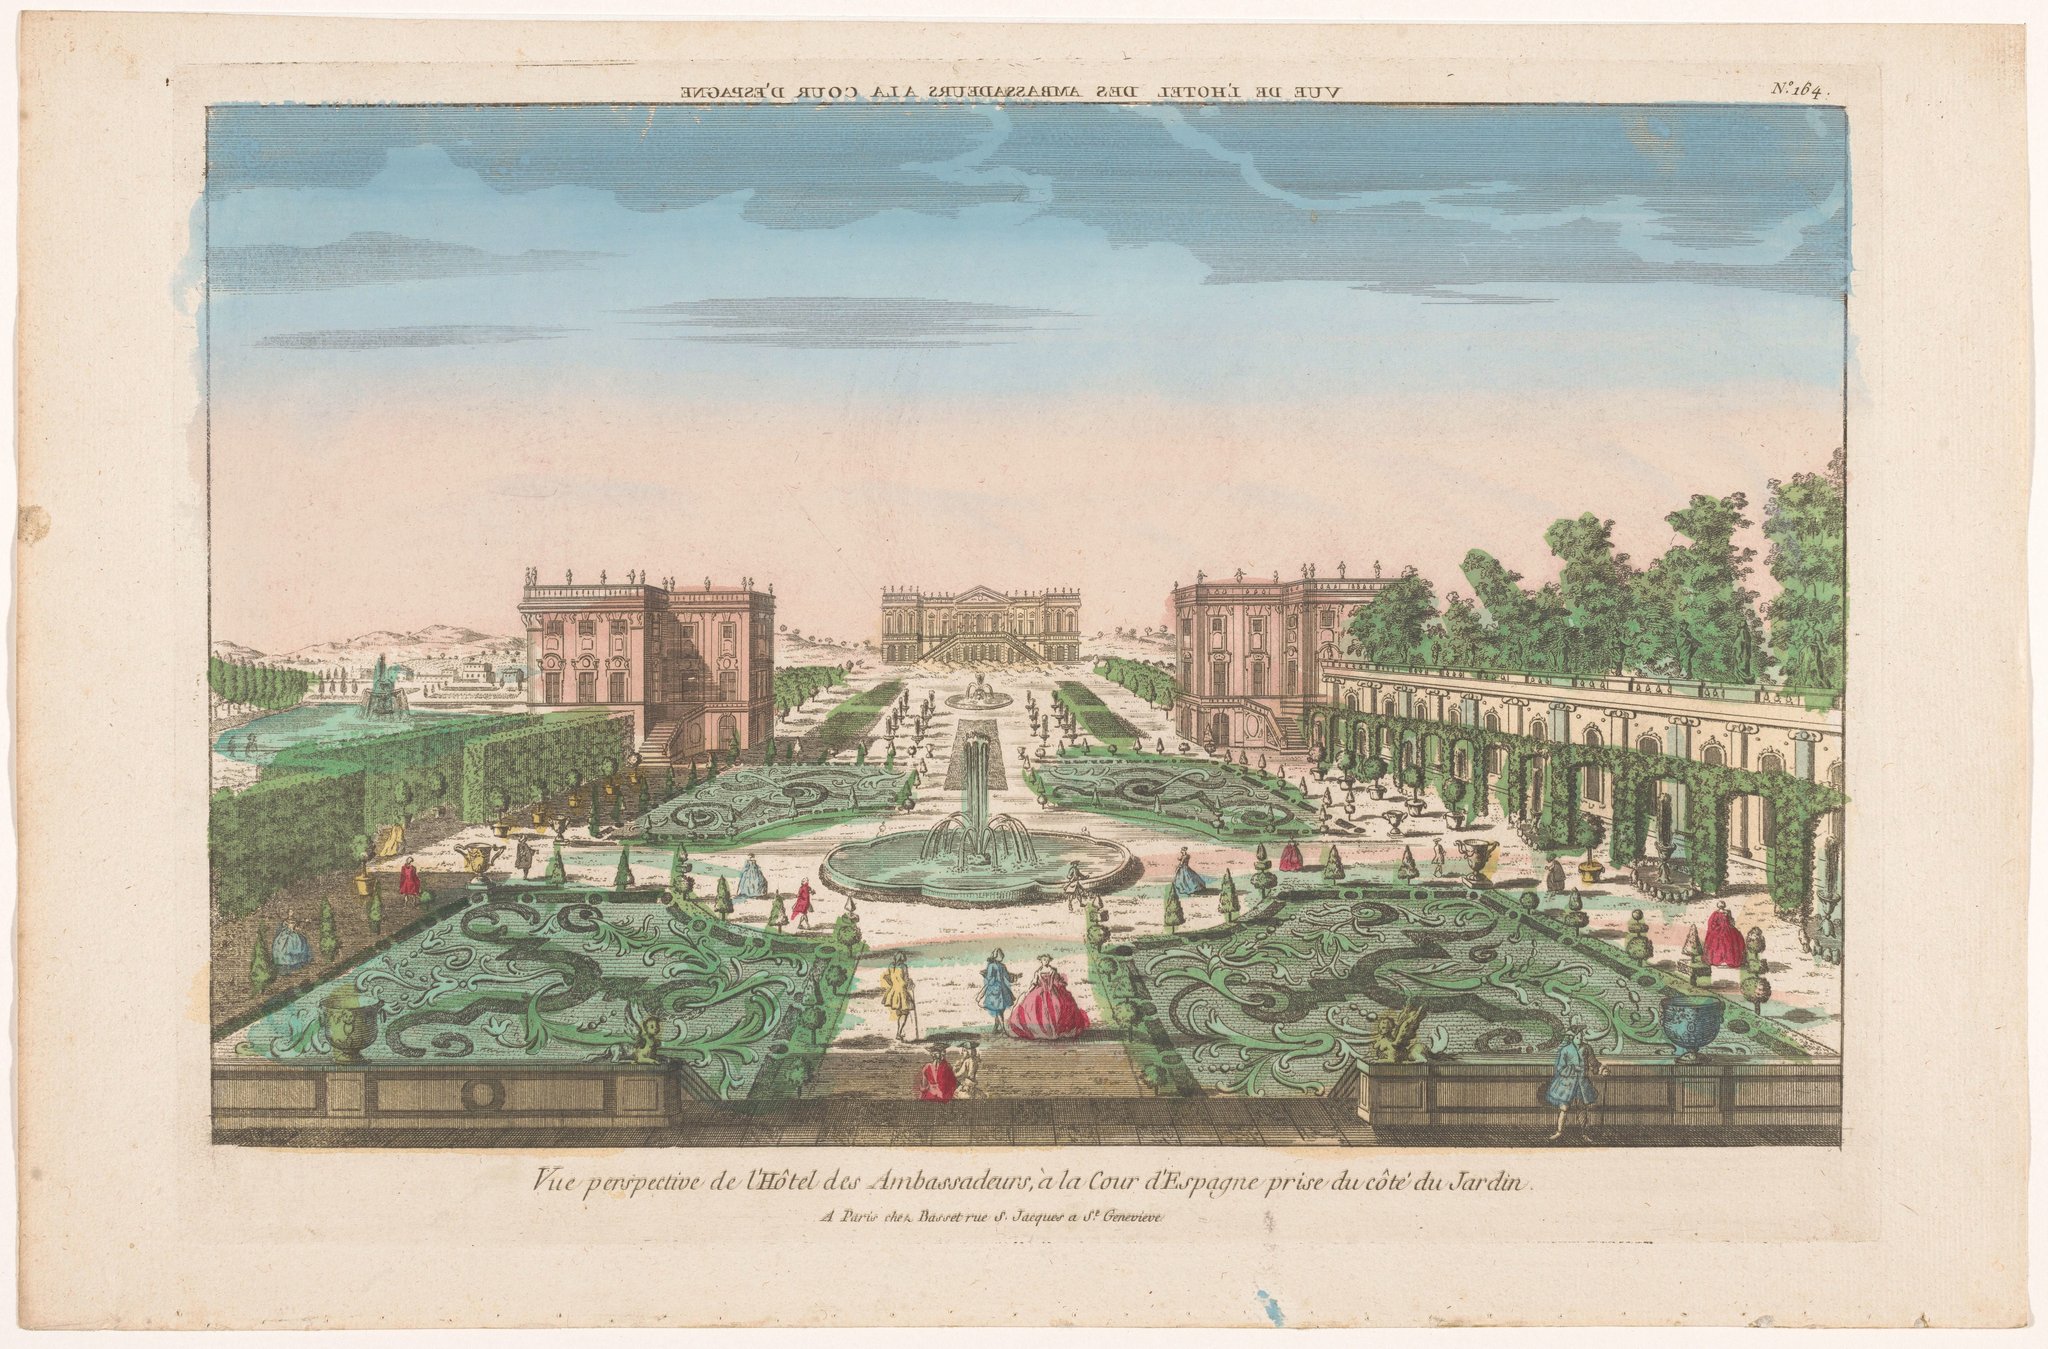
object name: print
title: Vue de l'Hotel des Ambassadeurs a la cour d'Espagne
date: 1700-1799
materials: paper, watercolor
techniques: brush, etching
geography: paris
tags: garden, garden fountain, ornamental plants, garden ornaments, civic architecture; edifices; dwellings, spain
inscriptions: watermark, collector's mark: Lugt 2166